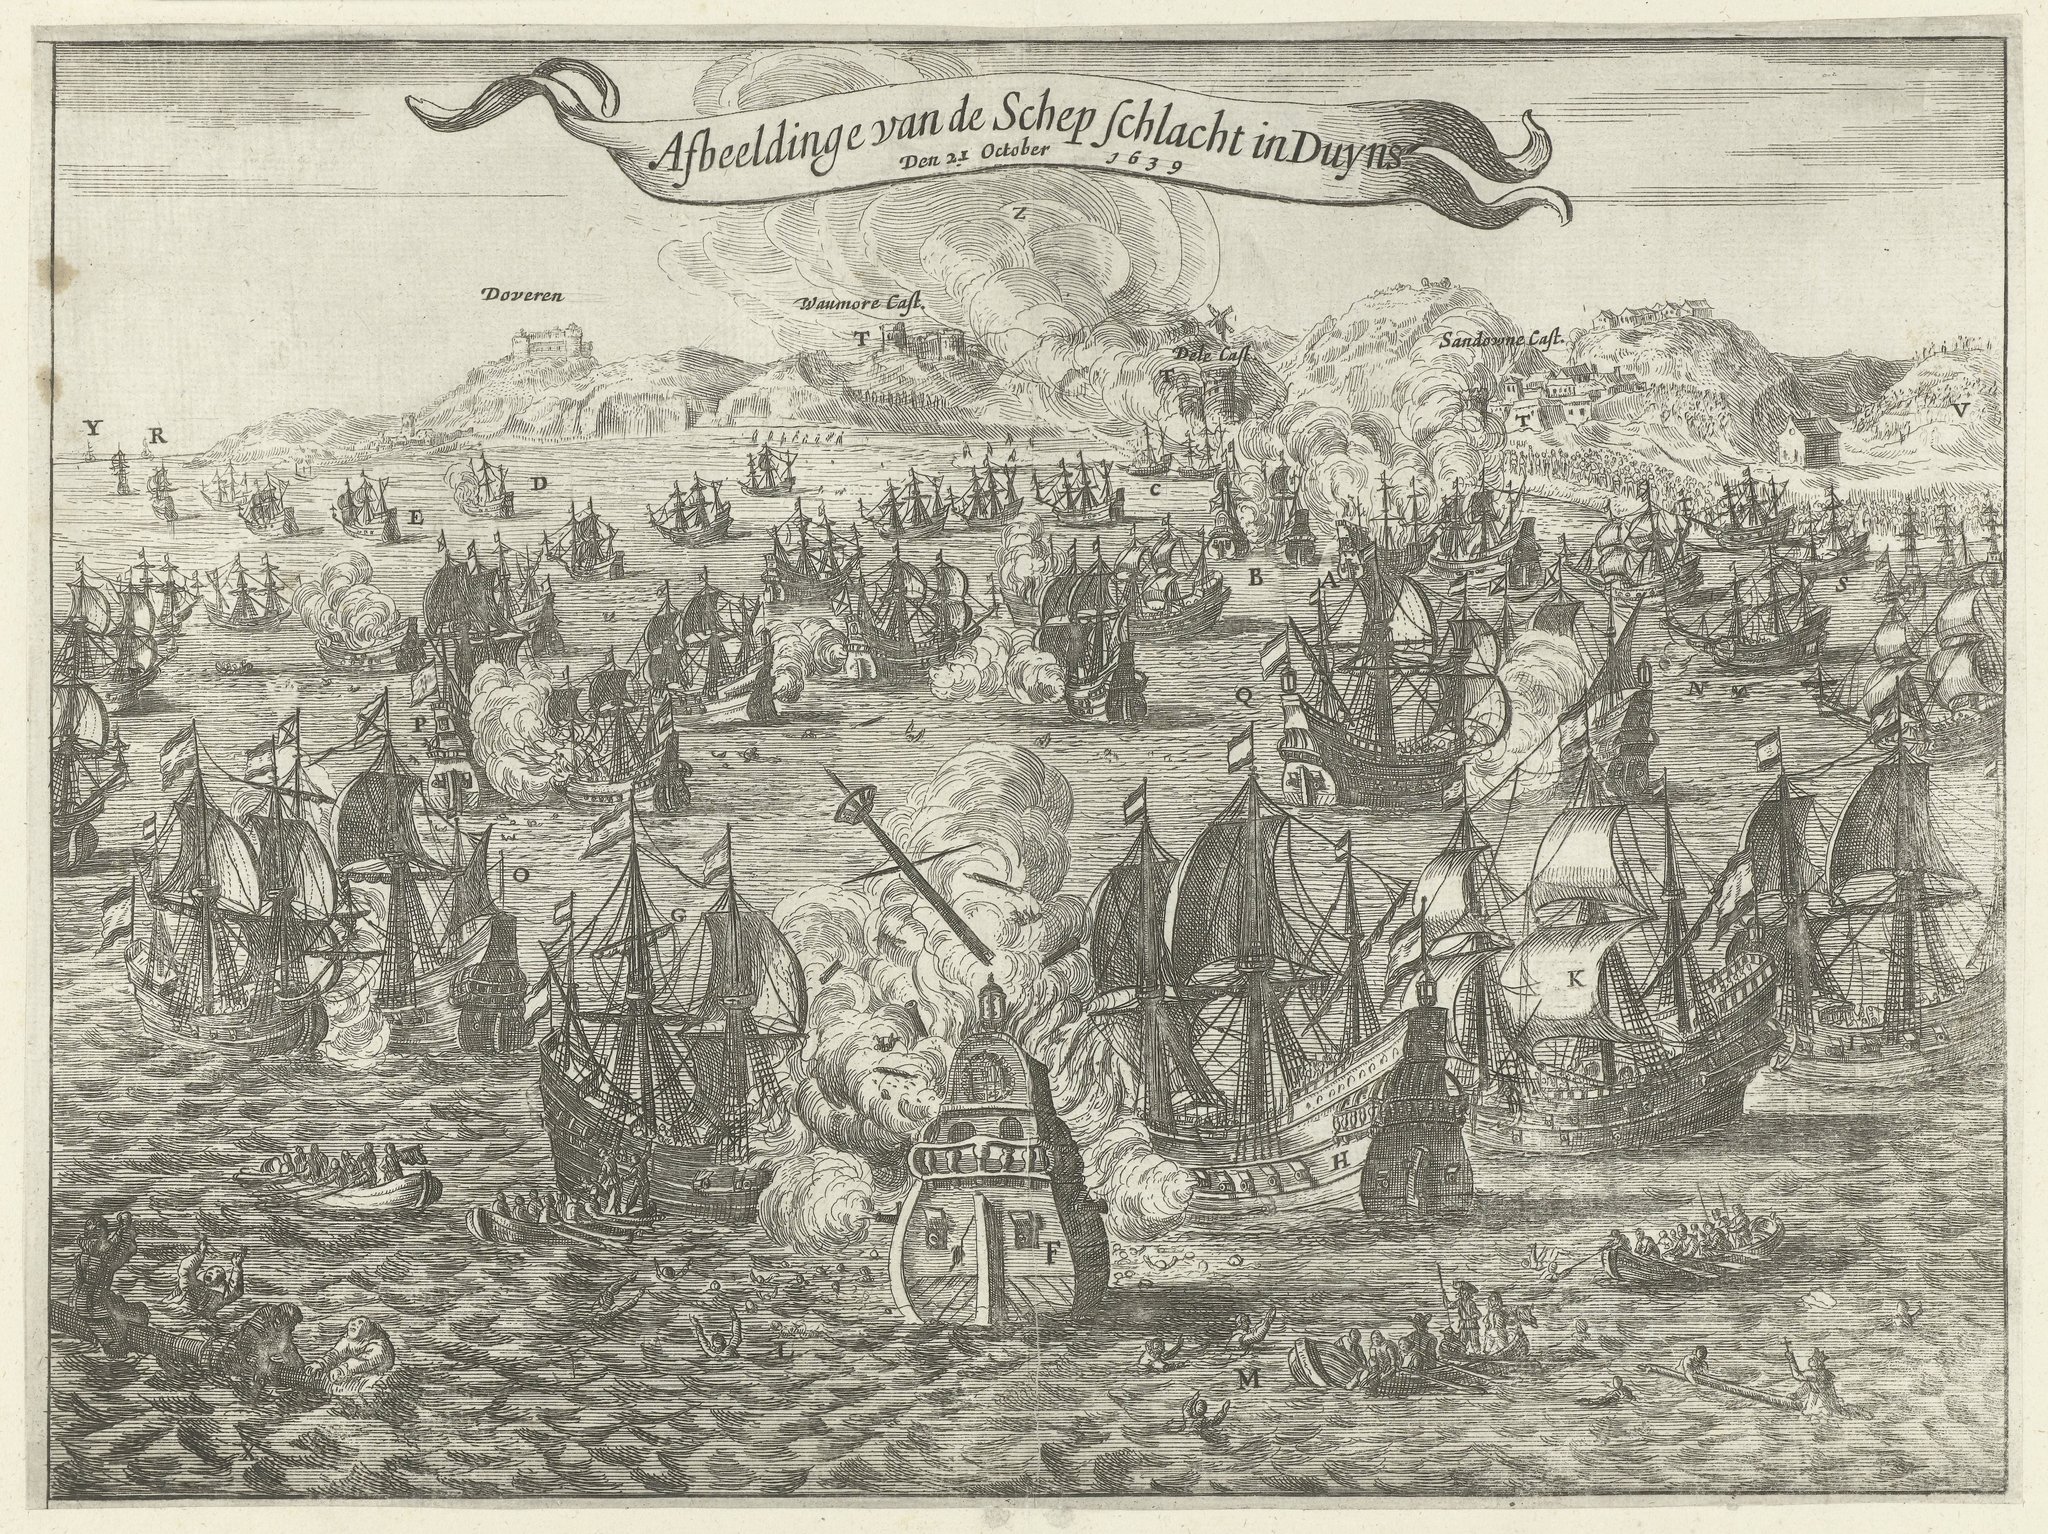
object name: print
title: Afbeeldinge van de Schep schlacht in Duyns Den 21 October 1639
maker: crispijn van de passe (ii)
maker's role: draughtsman, print maker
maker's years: 1594-1670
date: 1639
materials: paper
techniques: engraving, etching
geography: northern netherlands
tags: brielle, maarten harpertszoon tromp, battle (+ naval force), battle of the downs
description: De zeeslag bij Duins tussen de Spaanse vloot onder bevel van Antonio de Oquendo en de Staatse vloot onder Maarten Harpertsz. Tromp, 21 oktober 1639. Centraal op de voorgrond een ontploffend Spaans schip. Op de achtergrond de Engelse kust. Zonder tekst en legenda.